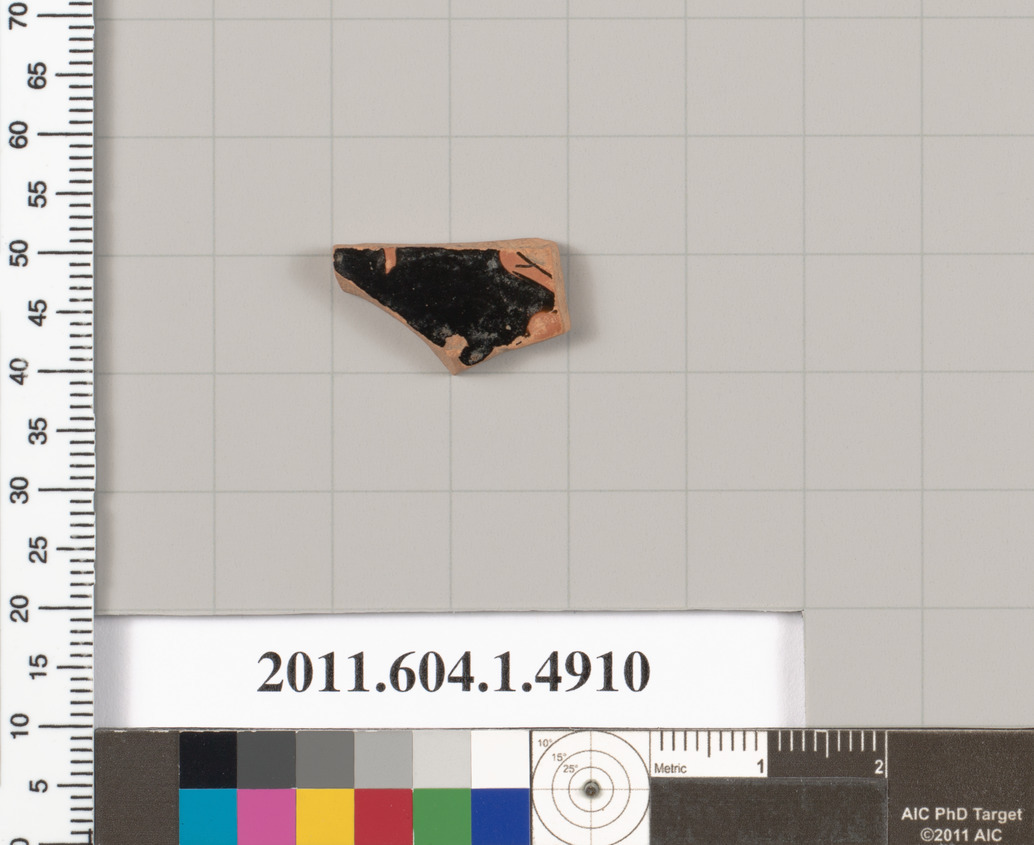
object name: kylix fragment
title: Terracotta fragment of a kylix (drinking cup)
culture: greek, attic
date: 490-470 BCE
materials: terracotta